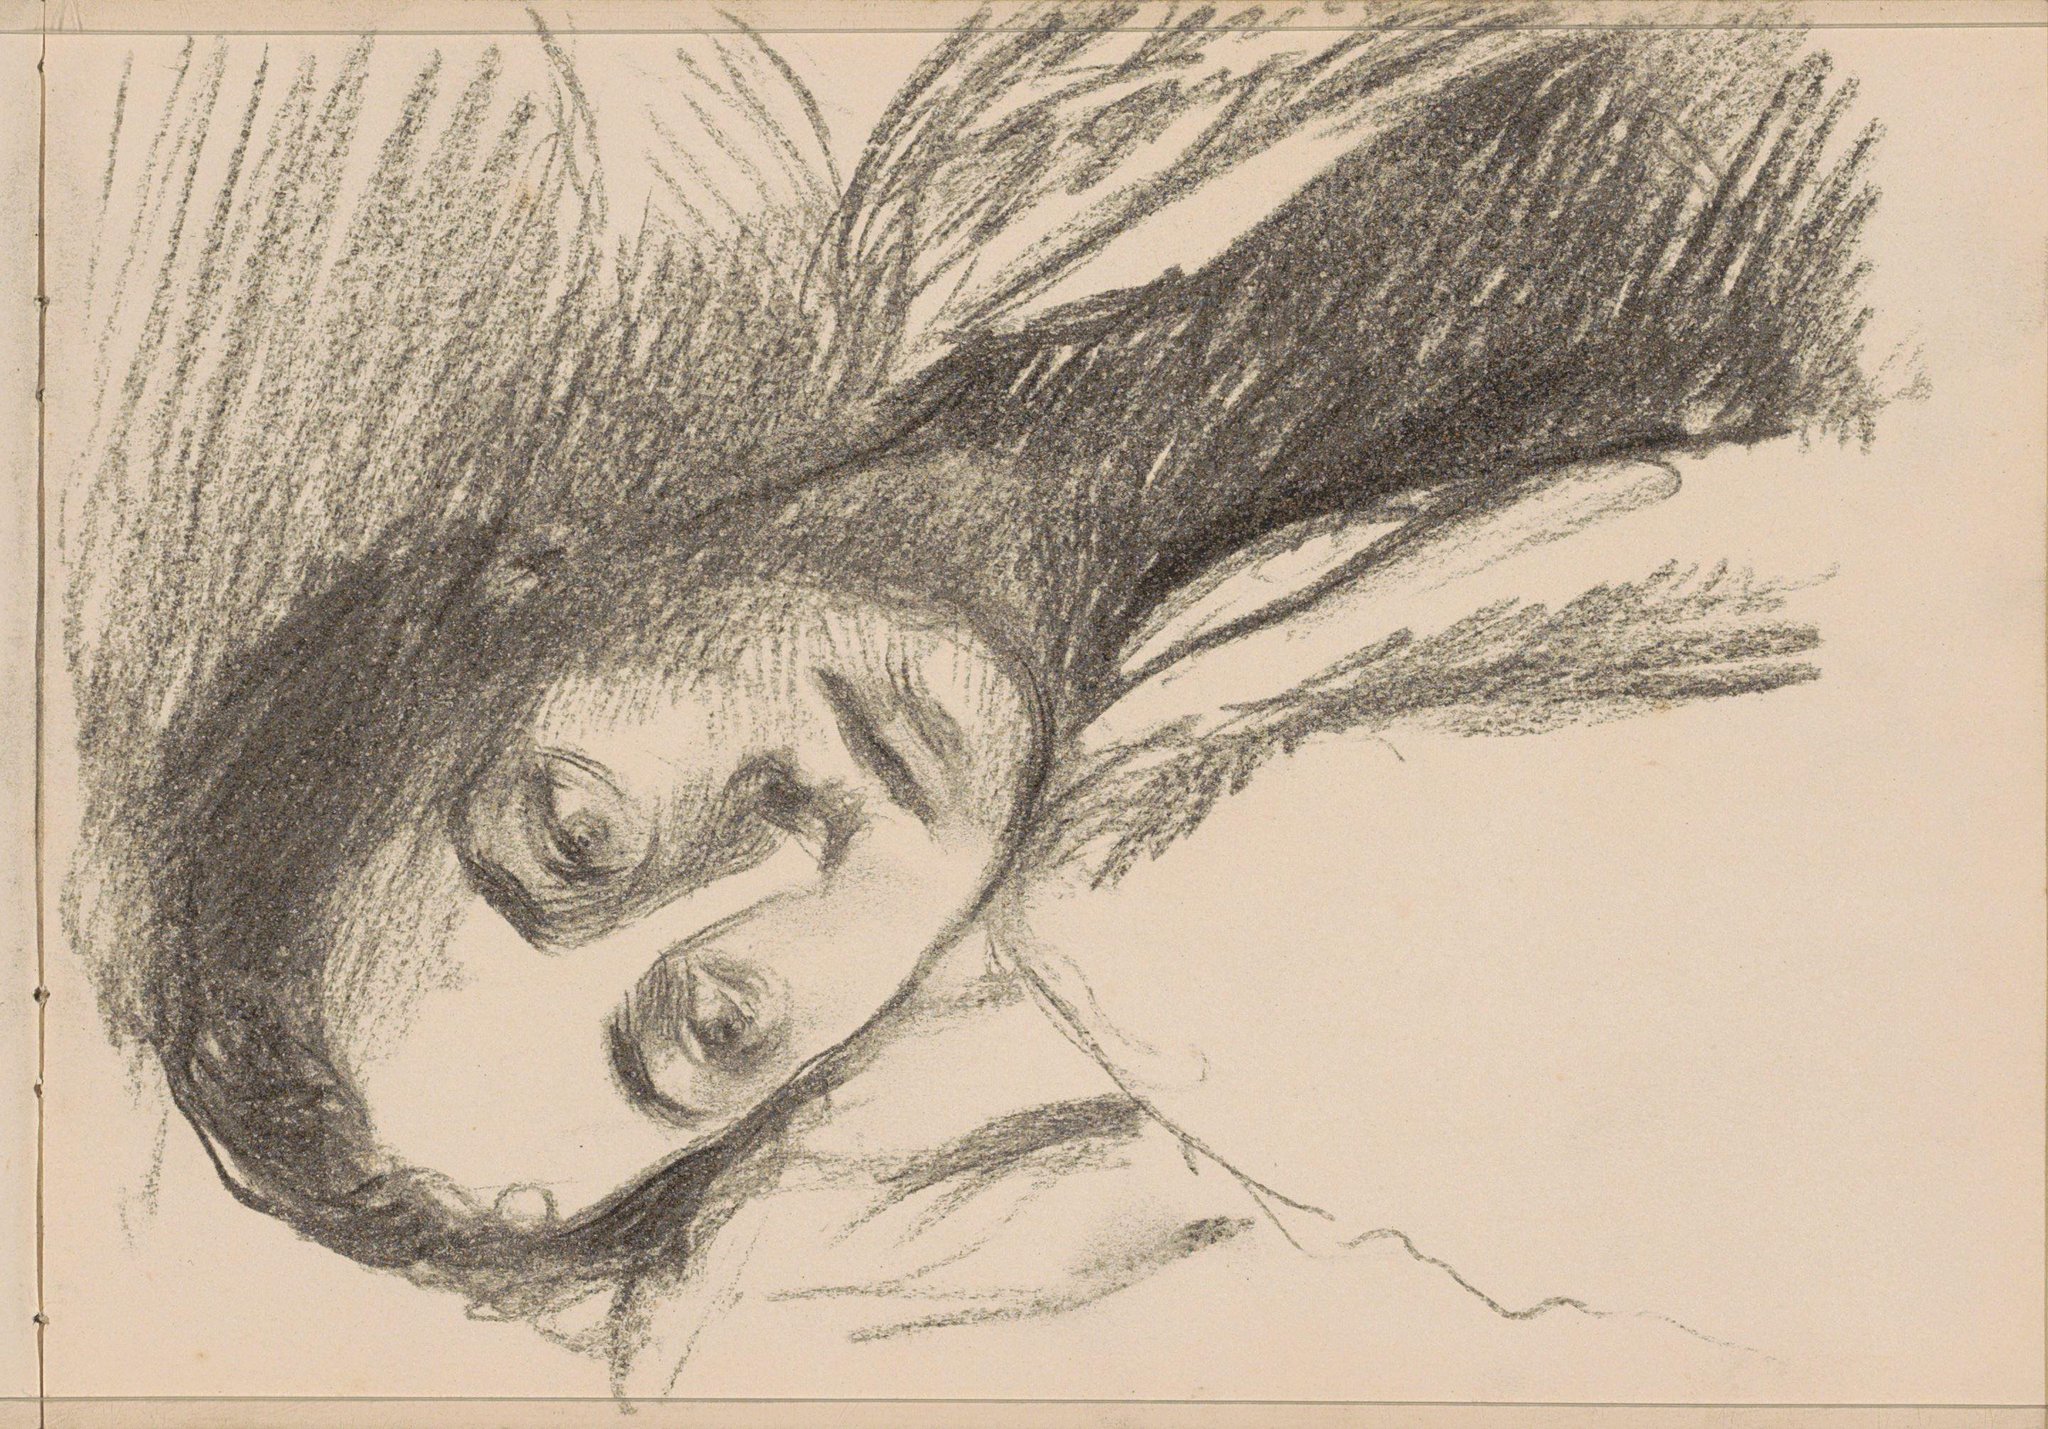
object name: sketchbook leaf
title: Portret van een vrouw, kijkend over de rechterschouder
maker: a.a.l. de grammont-hubrecht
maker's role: draughtsman, painter, print maker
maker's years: 1855-1913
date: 1865-1913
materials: chalk, paper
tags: looking over the shoulder - aa - female human figure, adult woman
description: Blad 38 recto uit een schetsboek met 68 bladen.